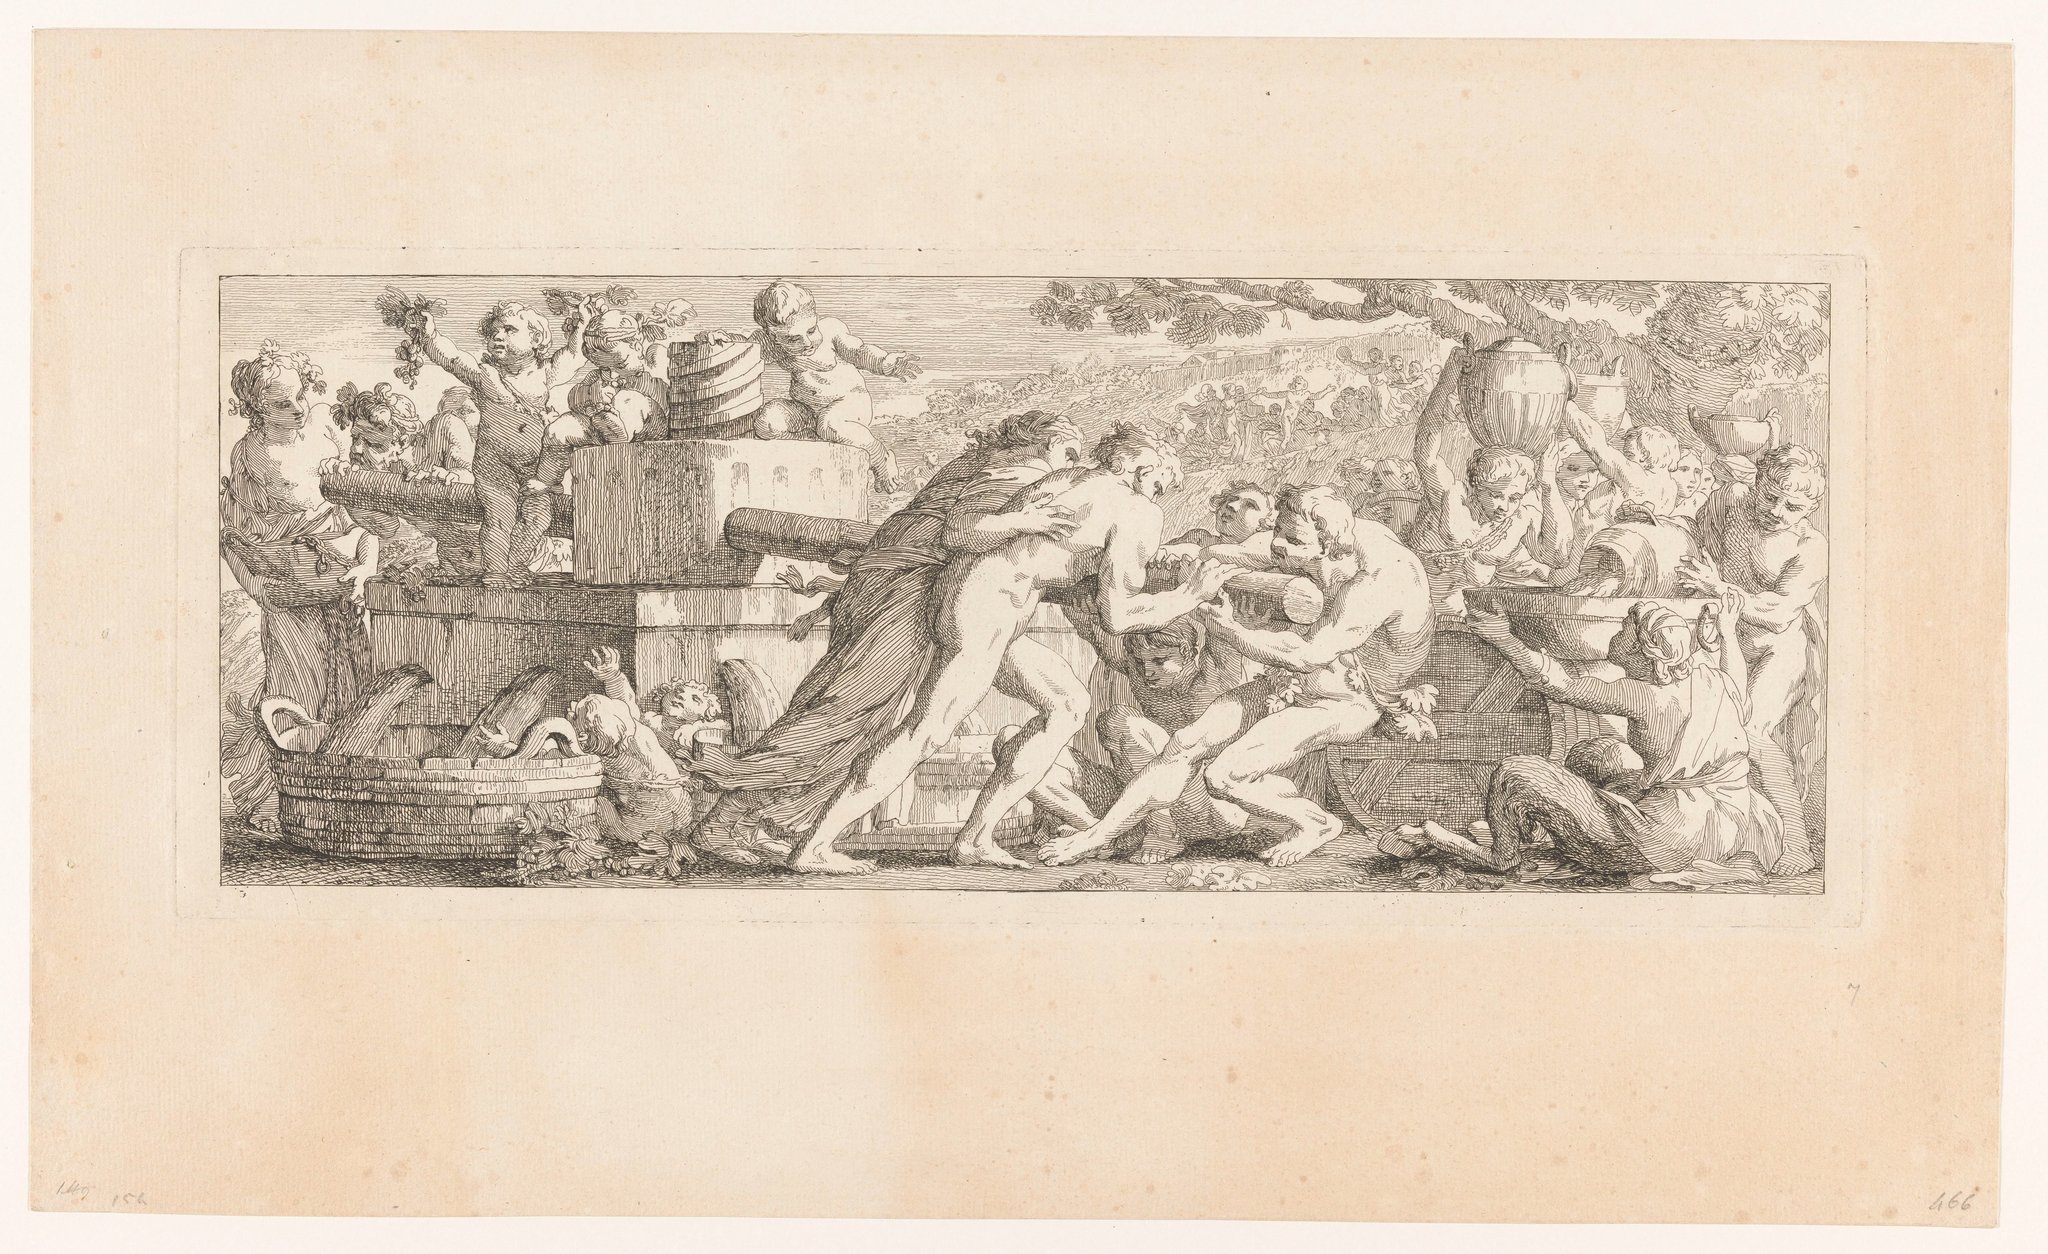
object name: print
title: Les travaux de la vendange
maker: joseph-marie vien (i)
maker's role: painter, print maker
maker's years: 1716-1809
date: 1750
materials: paper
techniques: etching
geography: rome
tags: maenad(s), female bacchant(es), male bacchant(es), wine-press, satyr(s) (in general)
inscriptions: collector's mark: Lugt 240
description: Bacchantische scène in friesvorm met bacchanten en saters. Links staat een wijnpers die in beweging wordt gebracht door verscheidene bacchanten. Rechts schenken overige figuren wijn in een schaal.